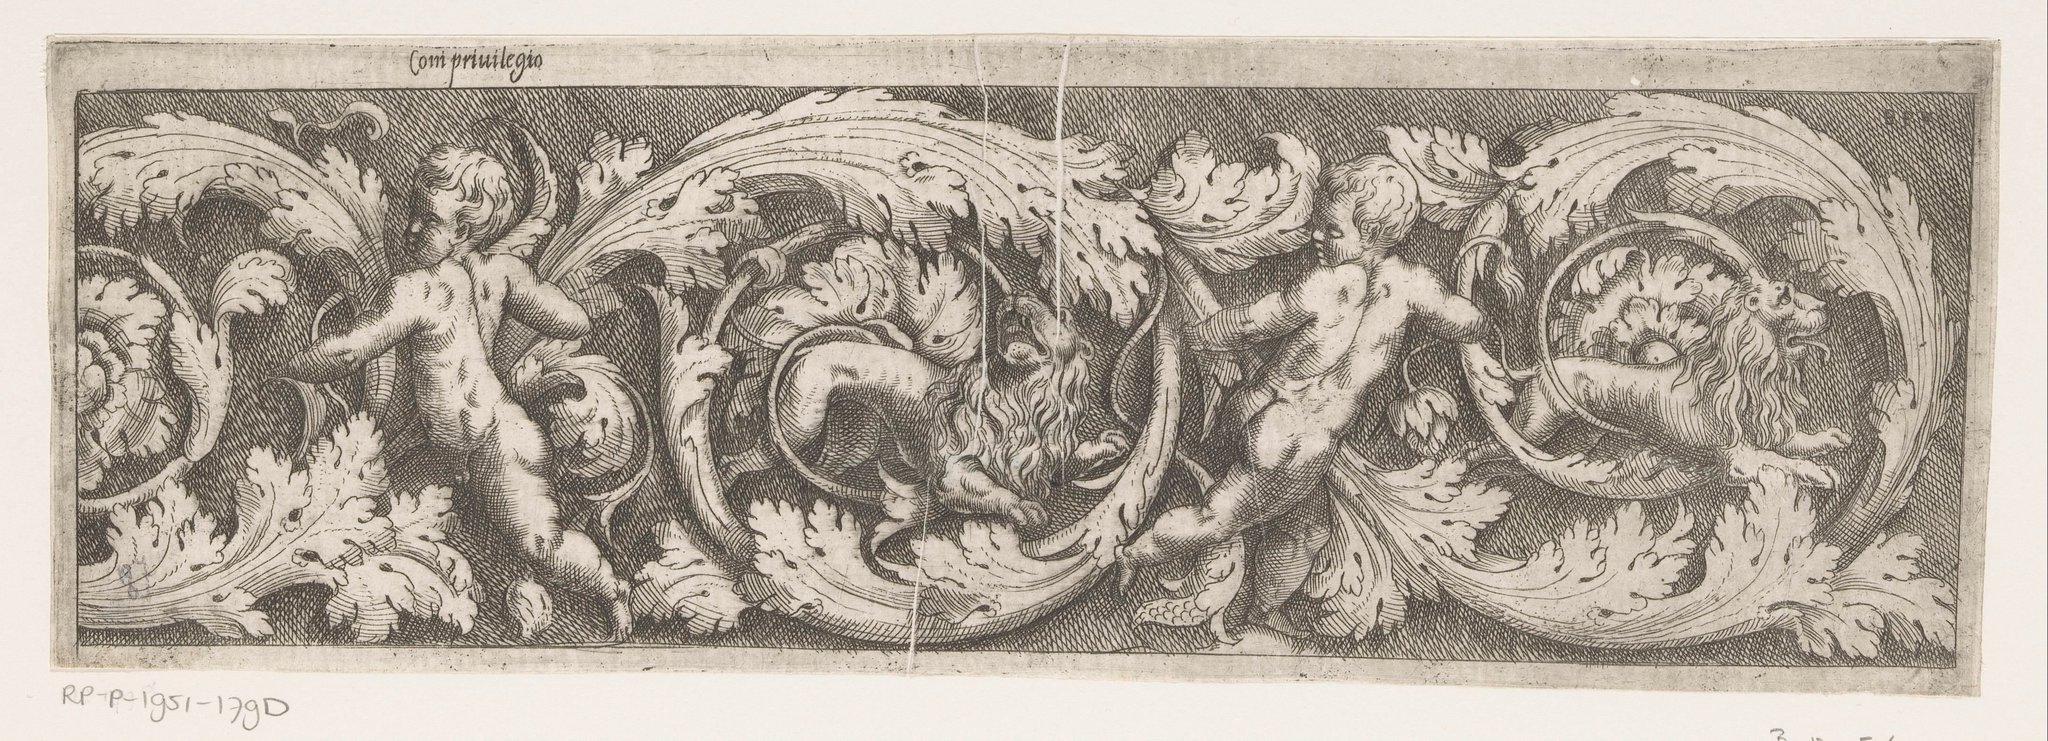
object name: ornament print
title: Fries met arabesken, twee putti en twee leeuwen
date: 1561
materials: paper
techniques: etching, intaglio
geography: italy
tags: ornaments ~ art, foliage ~ ornament, beasts of prey, predatory animals: lion, cupids: 'amores', 'amoretti', 'putti'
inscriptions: collector's mark: Lugt 2228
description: Deze prent maakt onderdeel uit van een reeks.